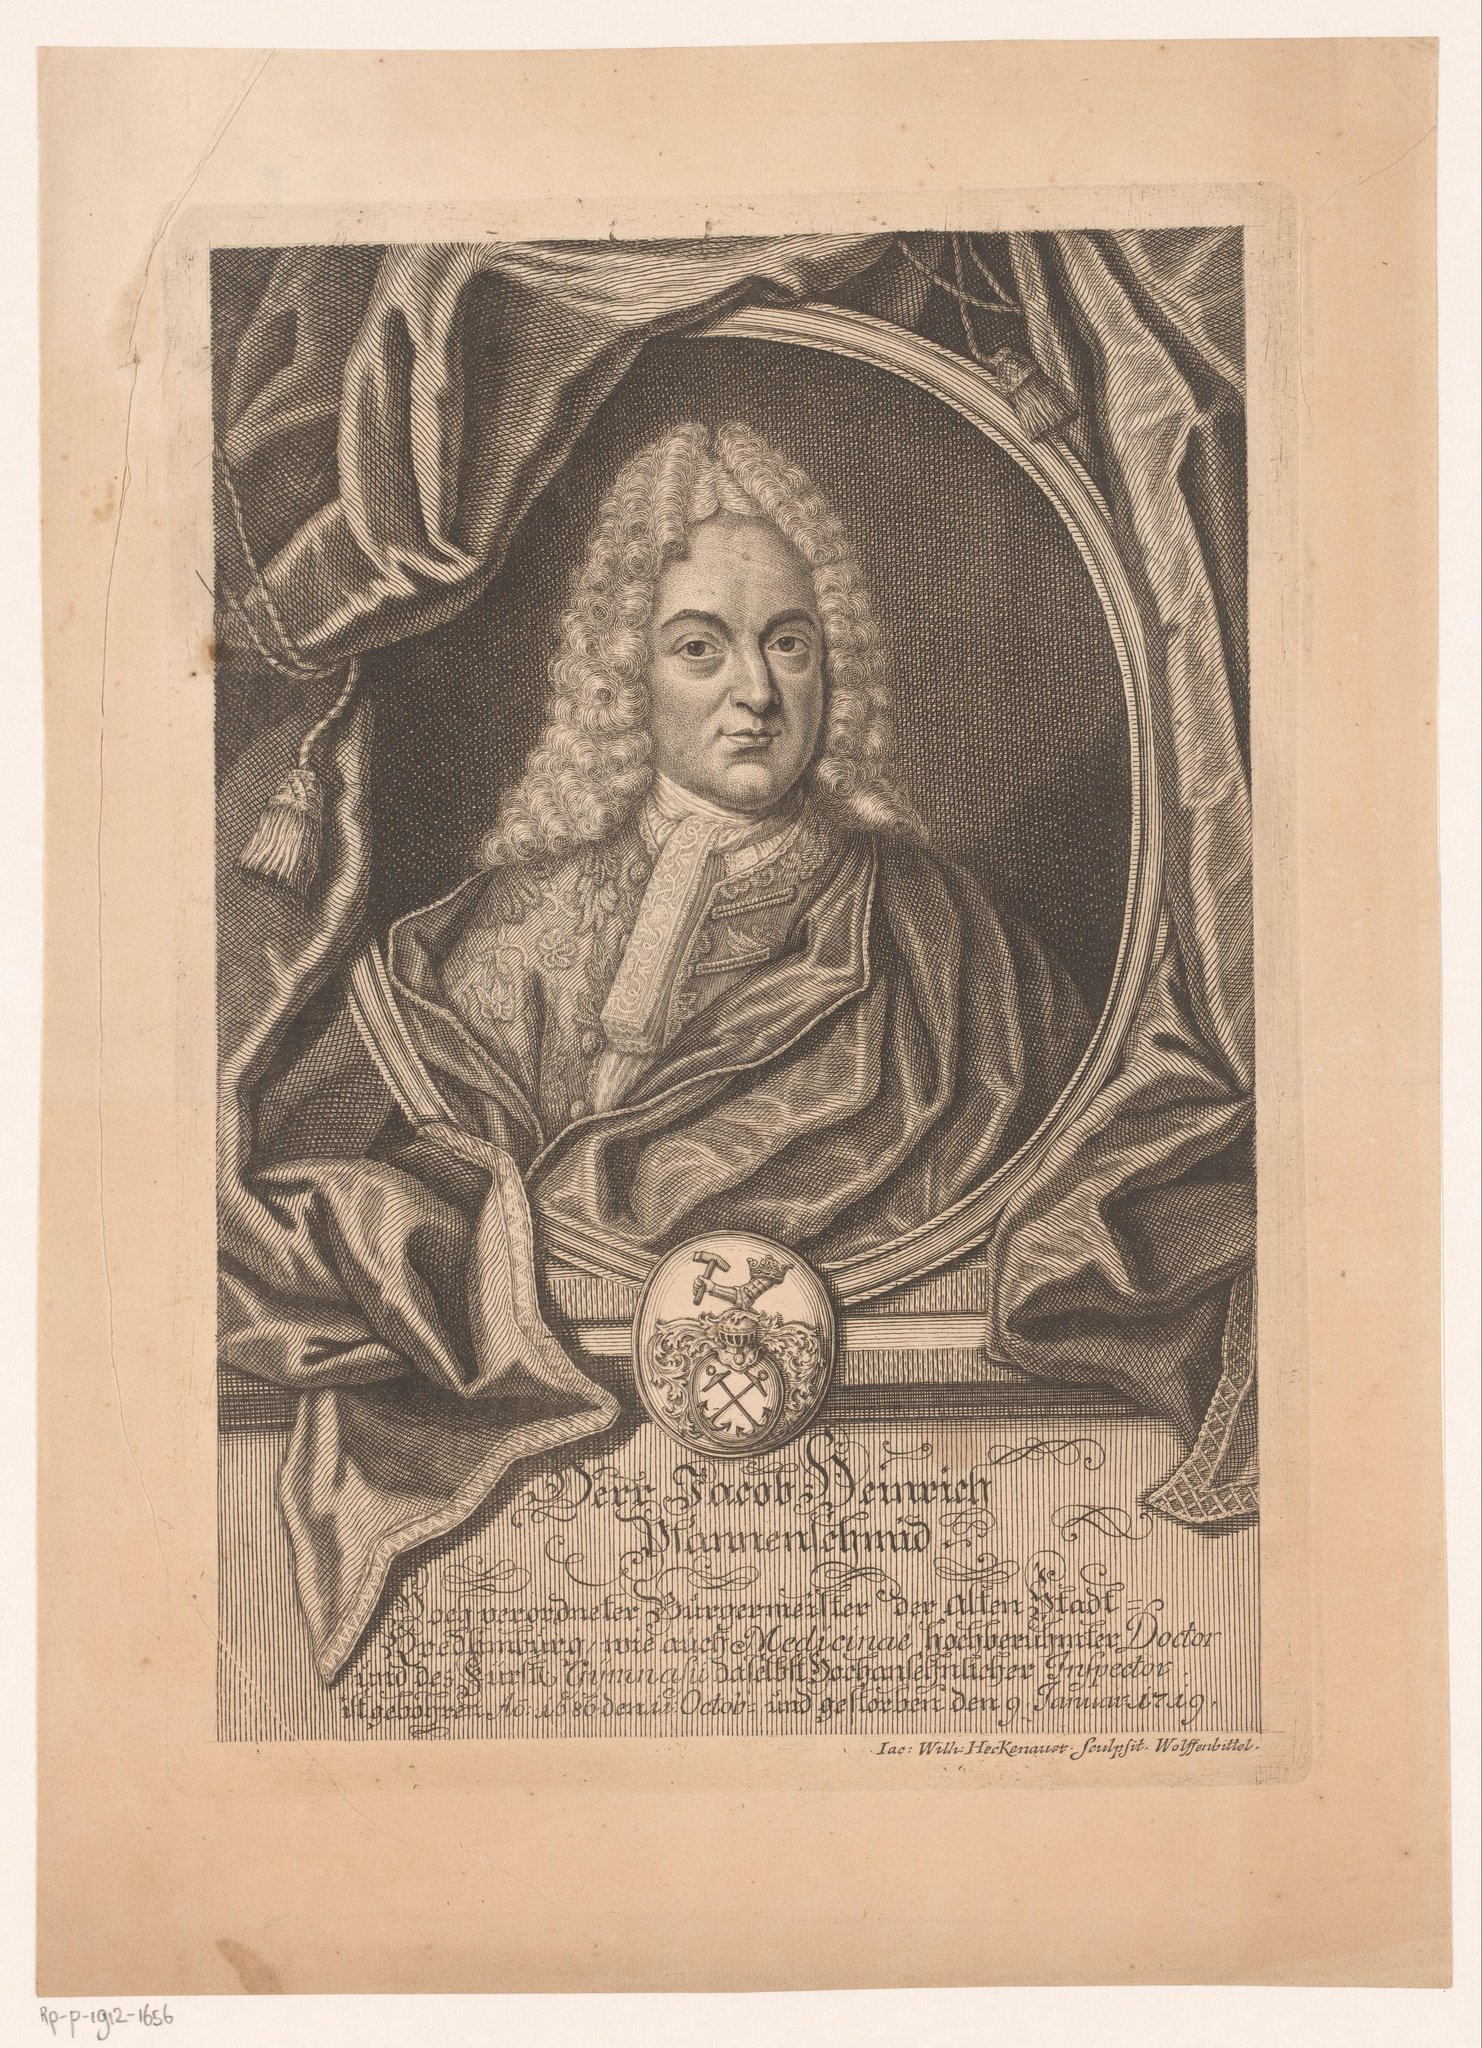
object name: print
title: Portret van Jakob Heinrich Pfannenschmidt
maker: jakob wilhelm heckenauer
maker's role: print maker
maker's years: 1696-1738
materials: paper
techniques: engraving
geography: wolfenbüttel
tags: mayor, historical persons, armorial bearing, heraldry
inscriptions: collector's mark: Lugt 2228